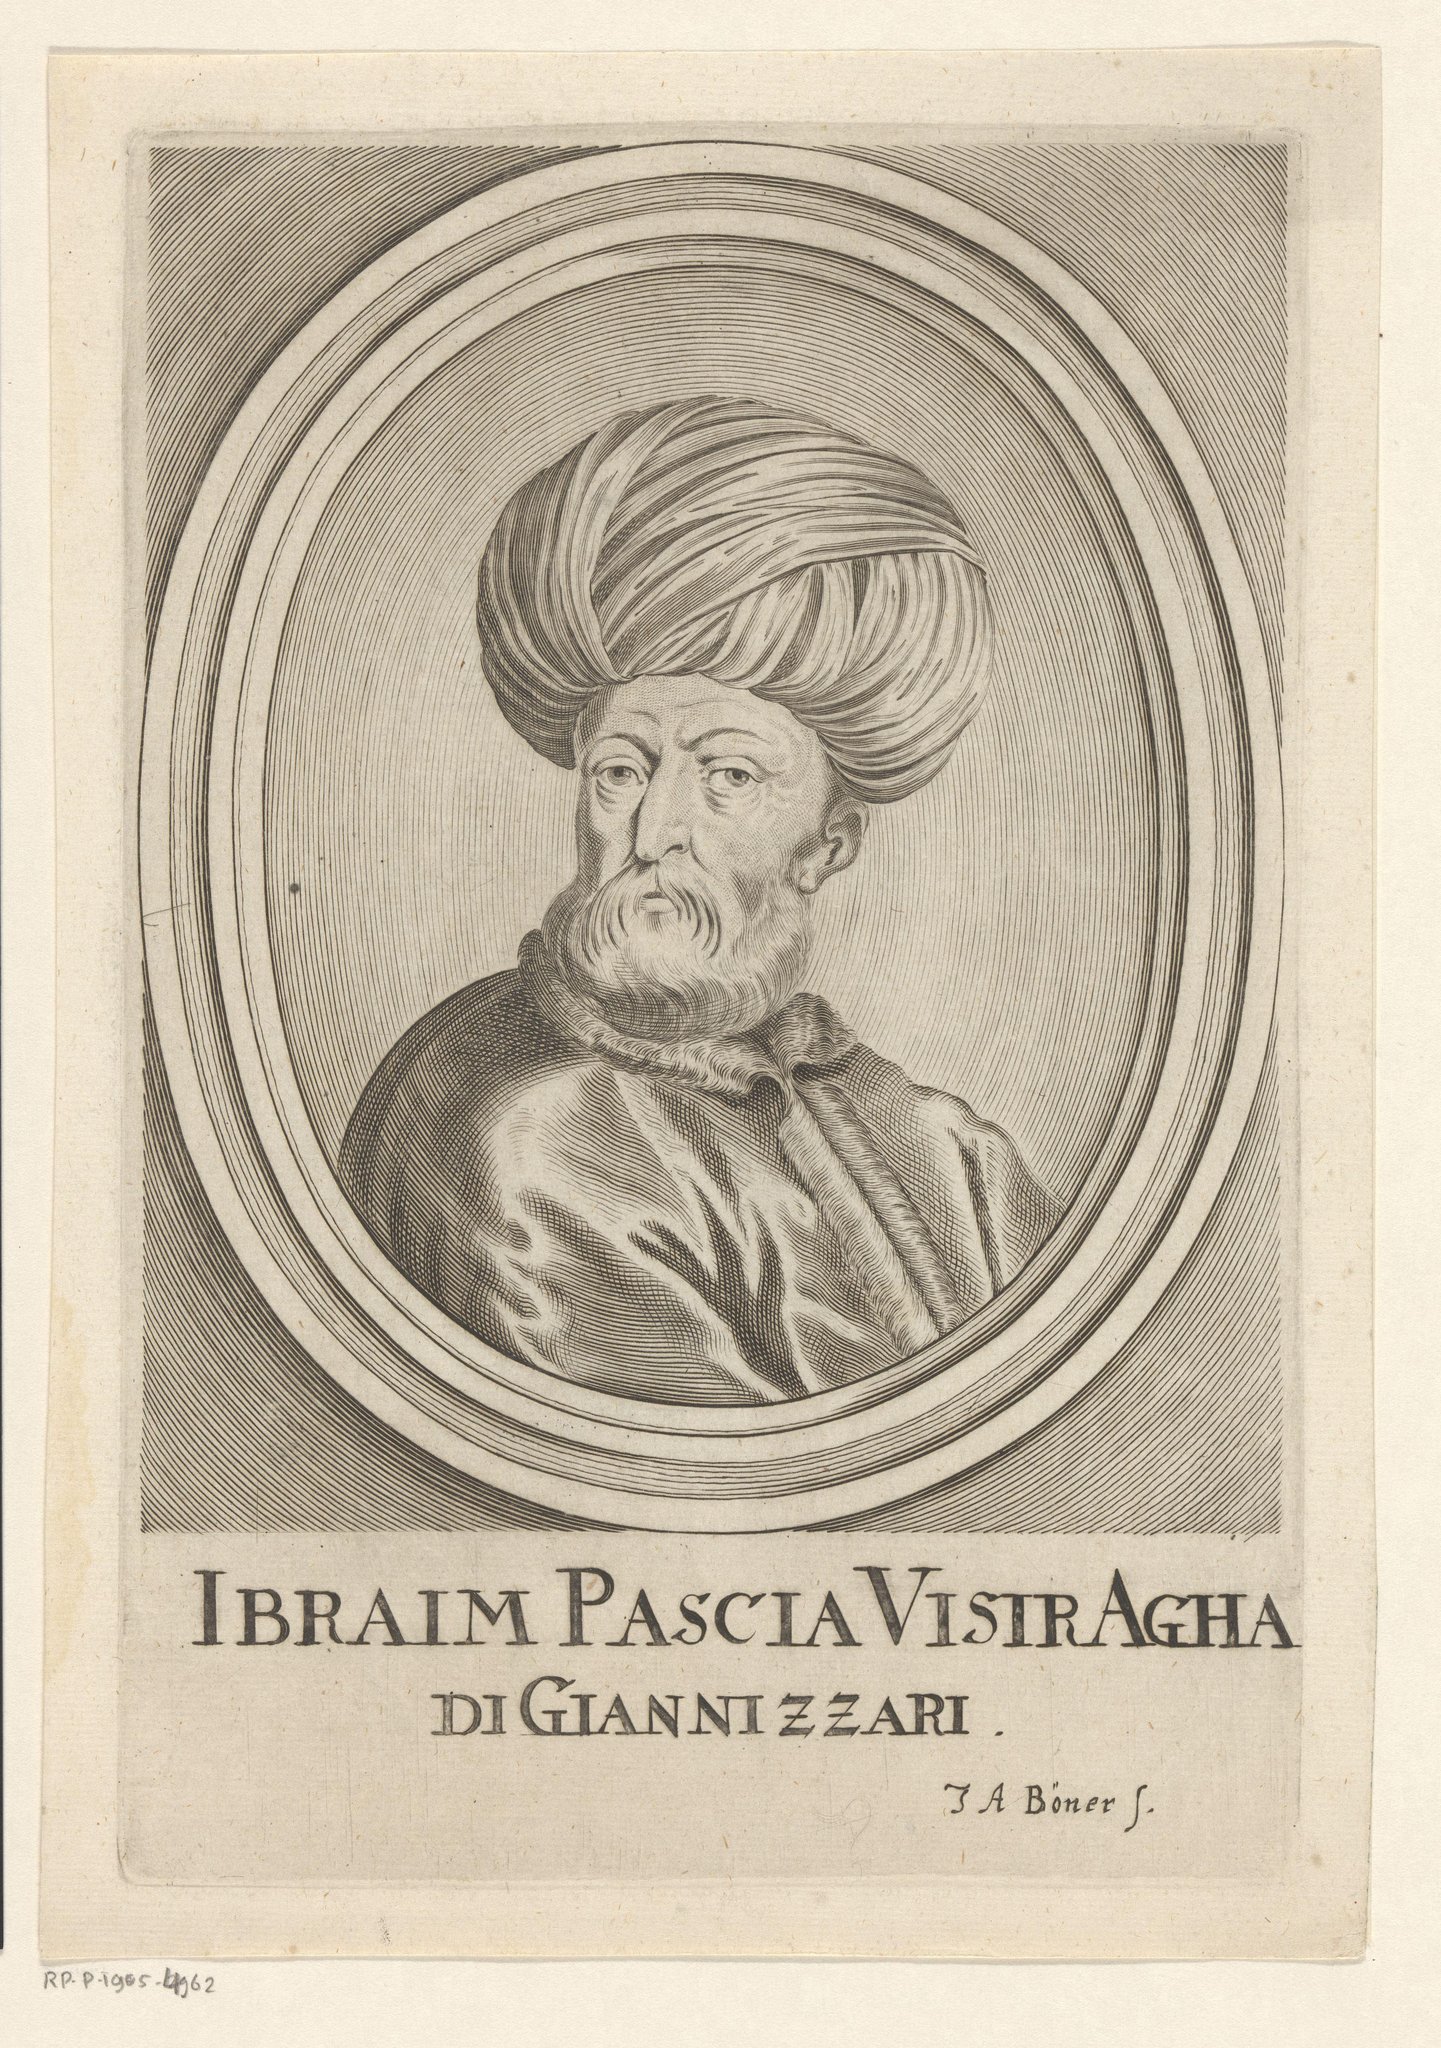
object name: print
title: Portret van Pargalı Ibrahim Pasha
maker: johann alexander böner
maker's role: draughtsman, print maker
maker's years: 1647-1720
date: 1674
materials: paper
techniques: engraving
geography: nuremberg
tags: historical persons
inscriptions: collector's mark: Lugt 2228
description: Prent ook gebruikt in: Gualdo Priorato, Galeazzo. Historia di Leopoldo Cesare. 3 dln. Wenen: Johann Baptist Hacque, 1670-1674, dl. 3 [1674], na p. 672.